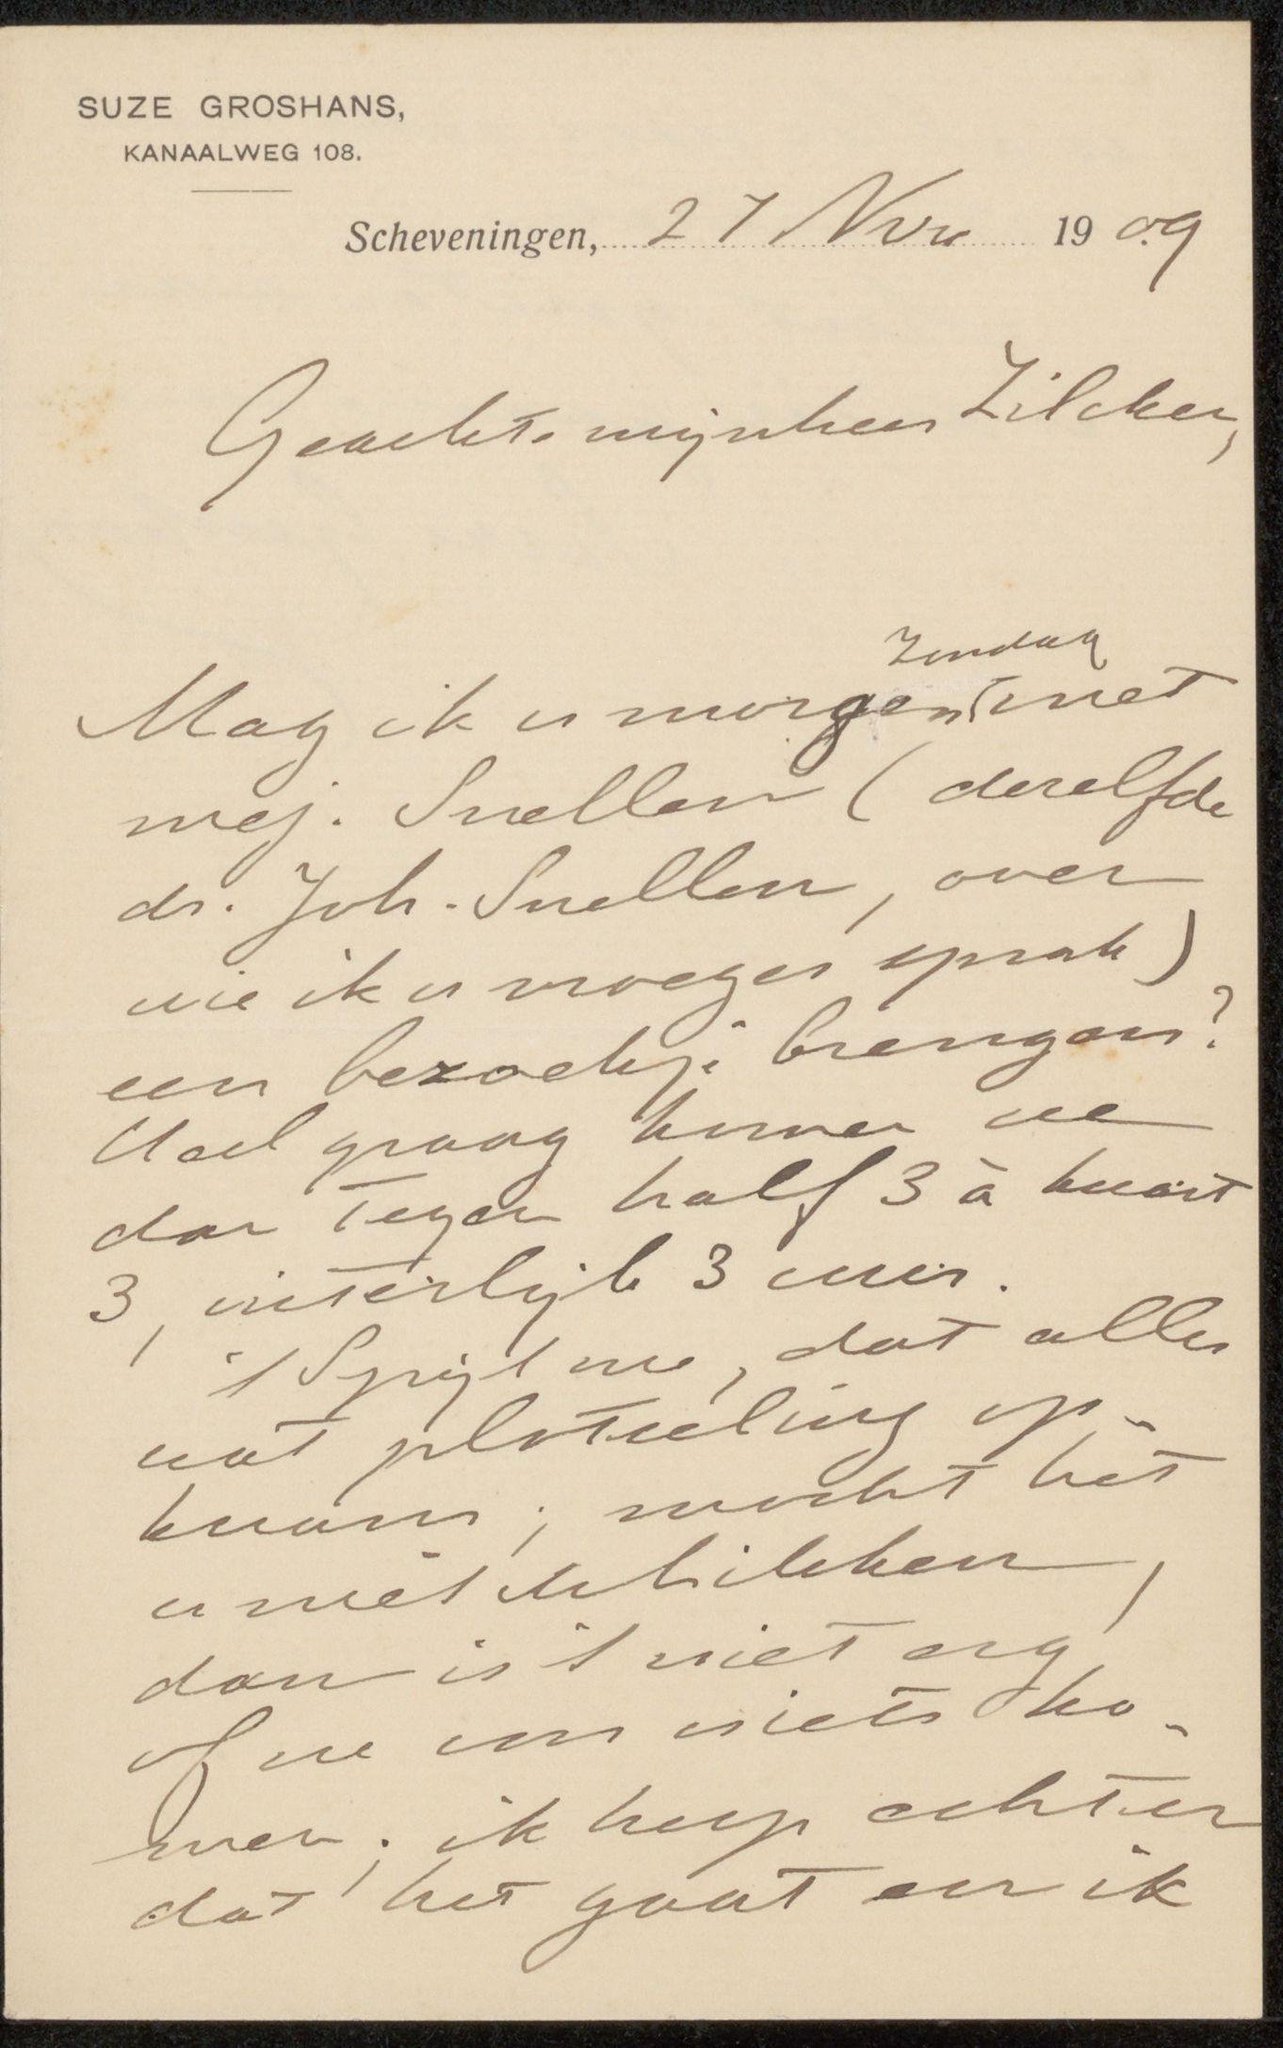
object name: letter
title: Brief aan Philip Zilcken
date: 1909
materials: ink, paper, pencil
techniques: pen, printing, writing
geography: scheveningen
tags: painter, draughtsman, philip zilcken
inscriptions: collector's mark: ‘RPK’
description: Aantekeningen van Philip Zilcken op envelop verso.